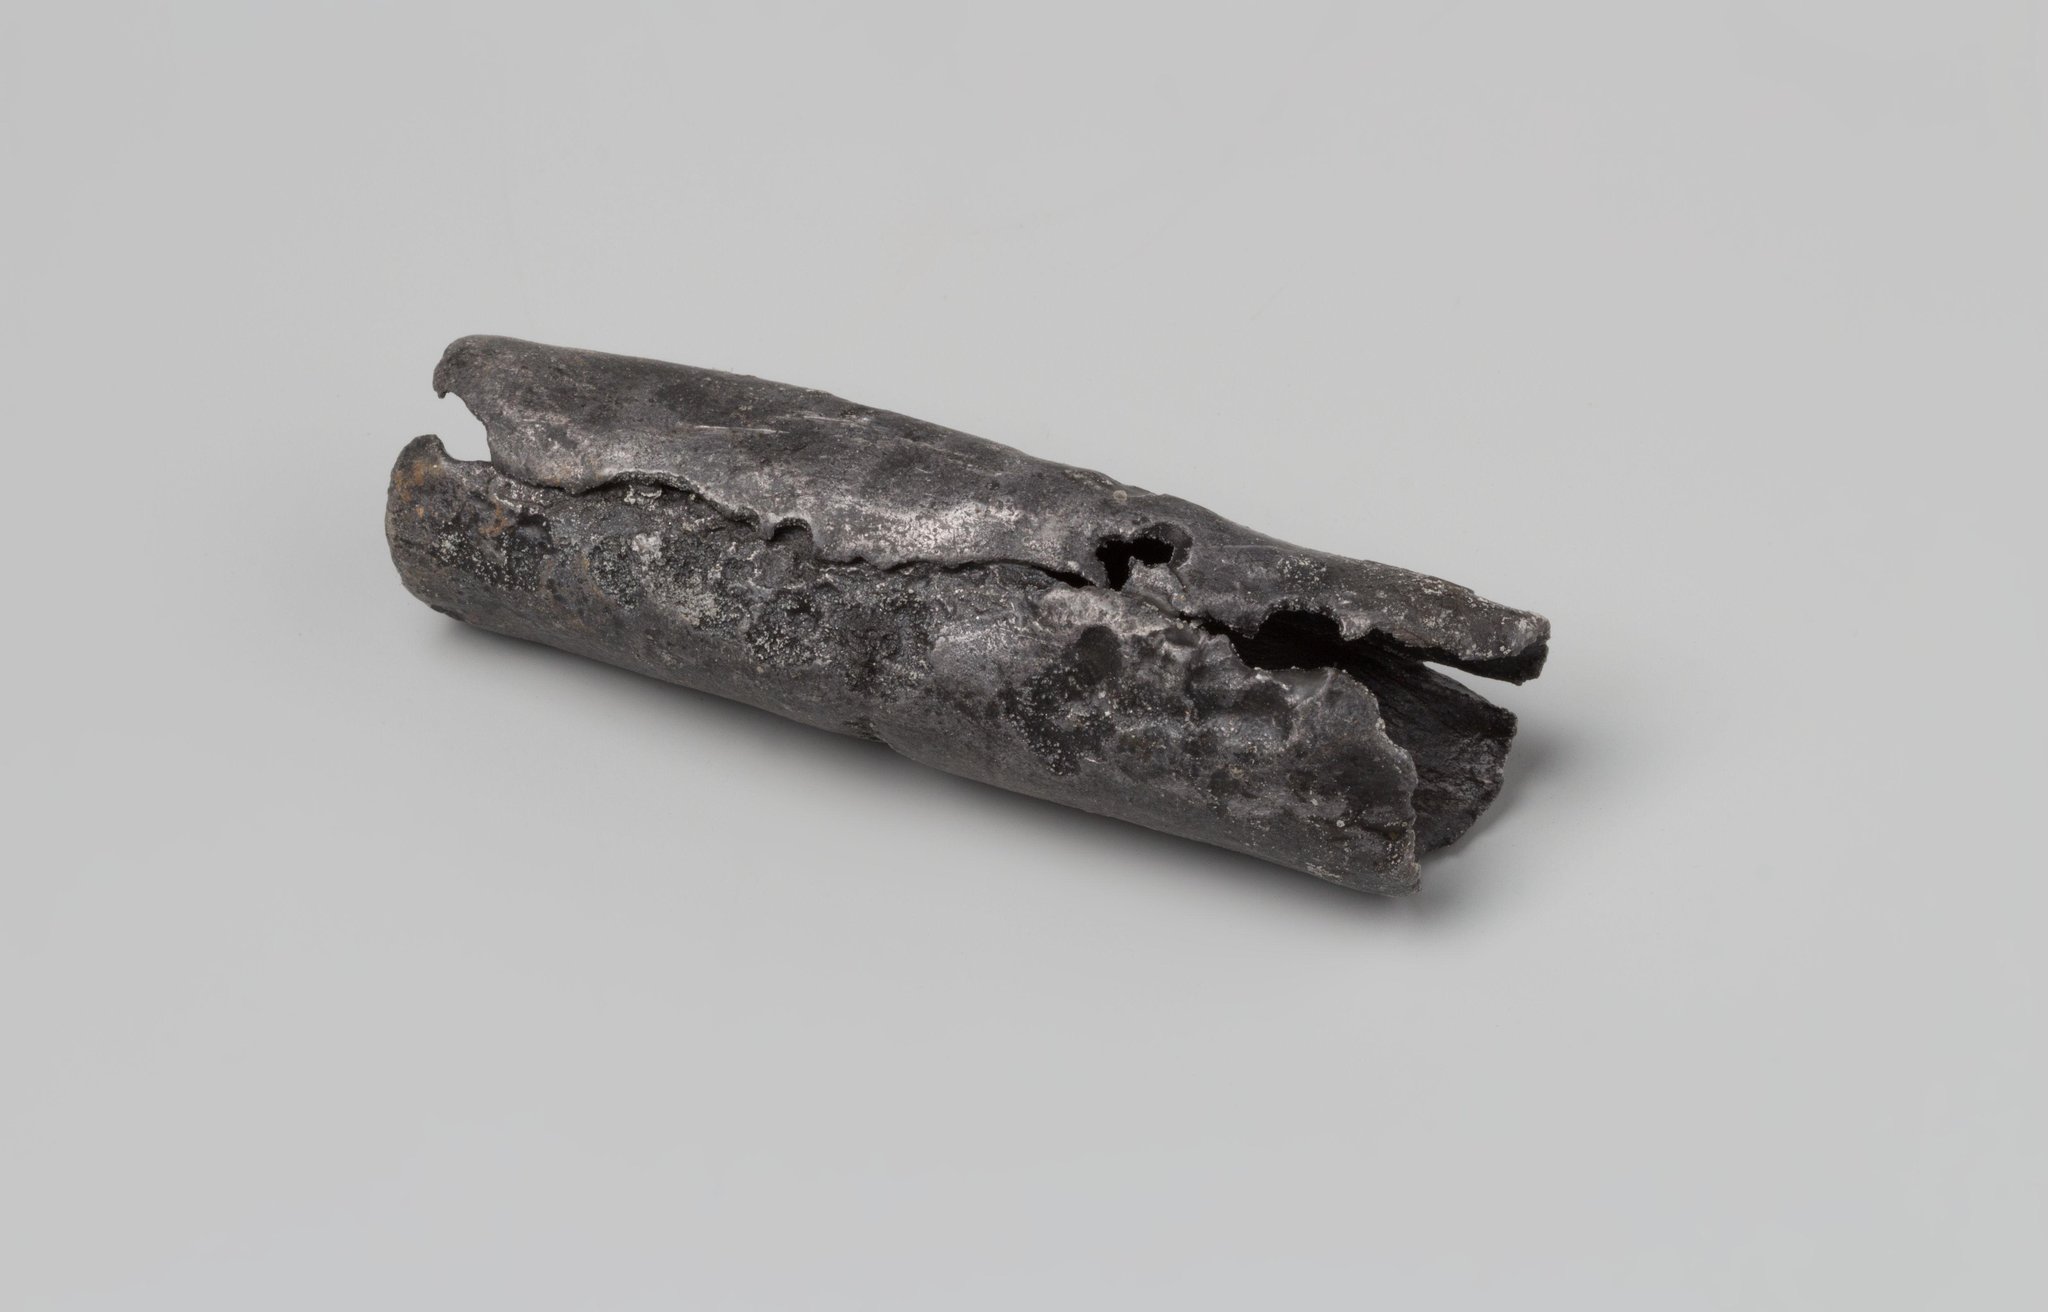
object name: lead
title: Loden rol uit het wrak van de Oost-Indiëvaarder 't Vliegend Hart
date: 1700-1735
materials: lead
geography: middelburg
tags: 't vliegend hart (schip), verenigde oostindische compagnie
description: Deze loden buisjes zijn vermoedelijk afkomstig van visnetten ofwel op TVliegend Hart zelf ofwel van vissers die hun netten aan het wrak verloren.